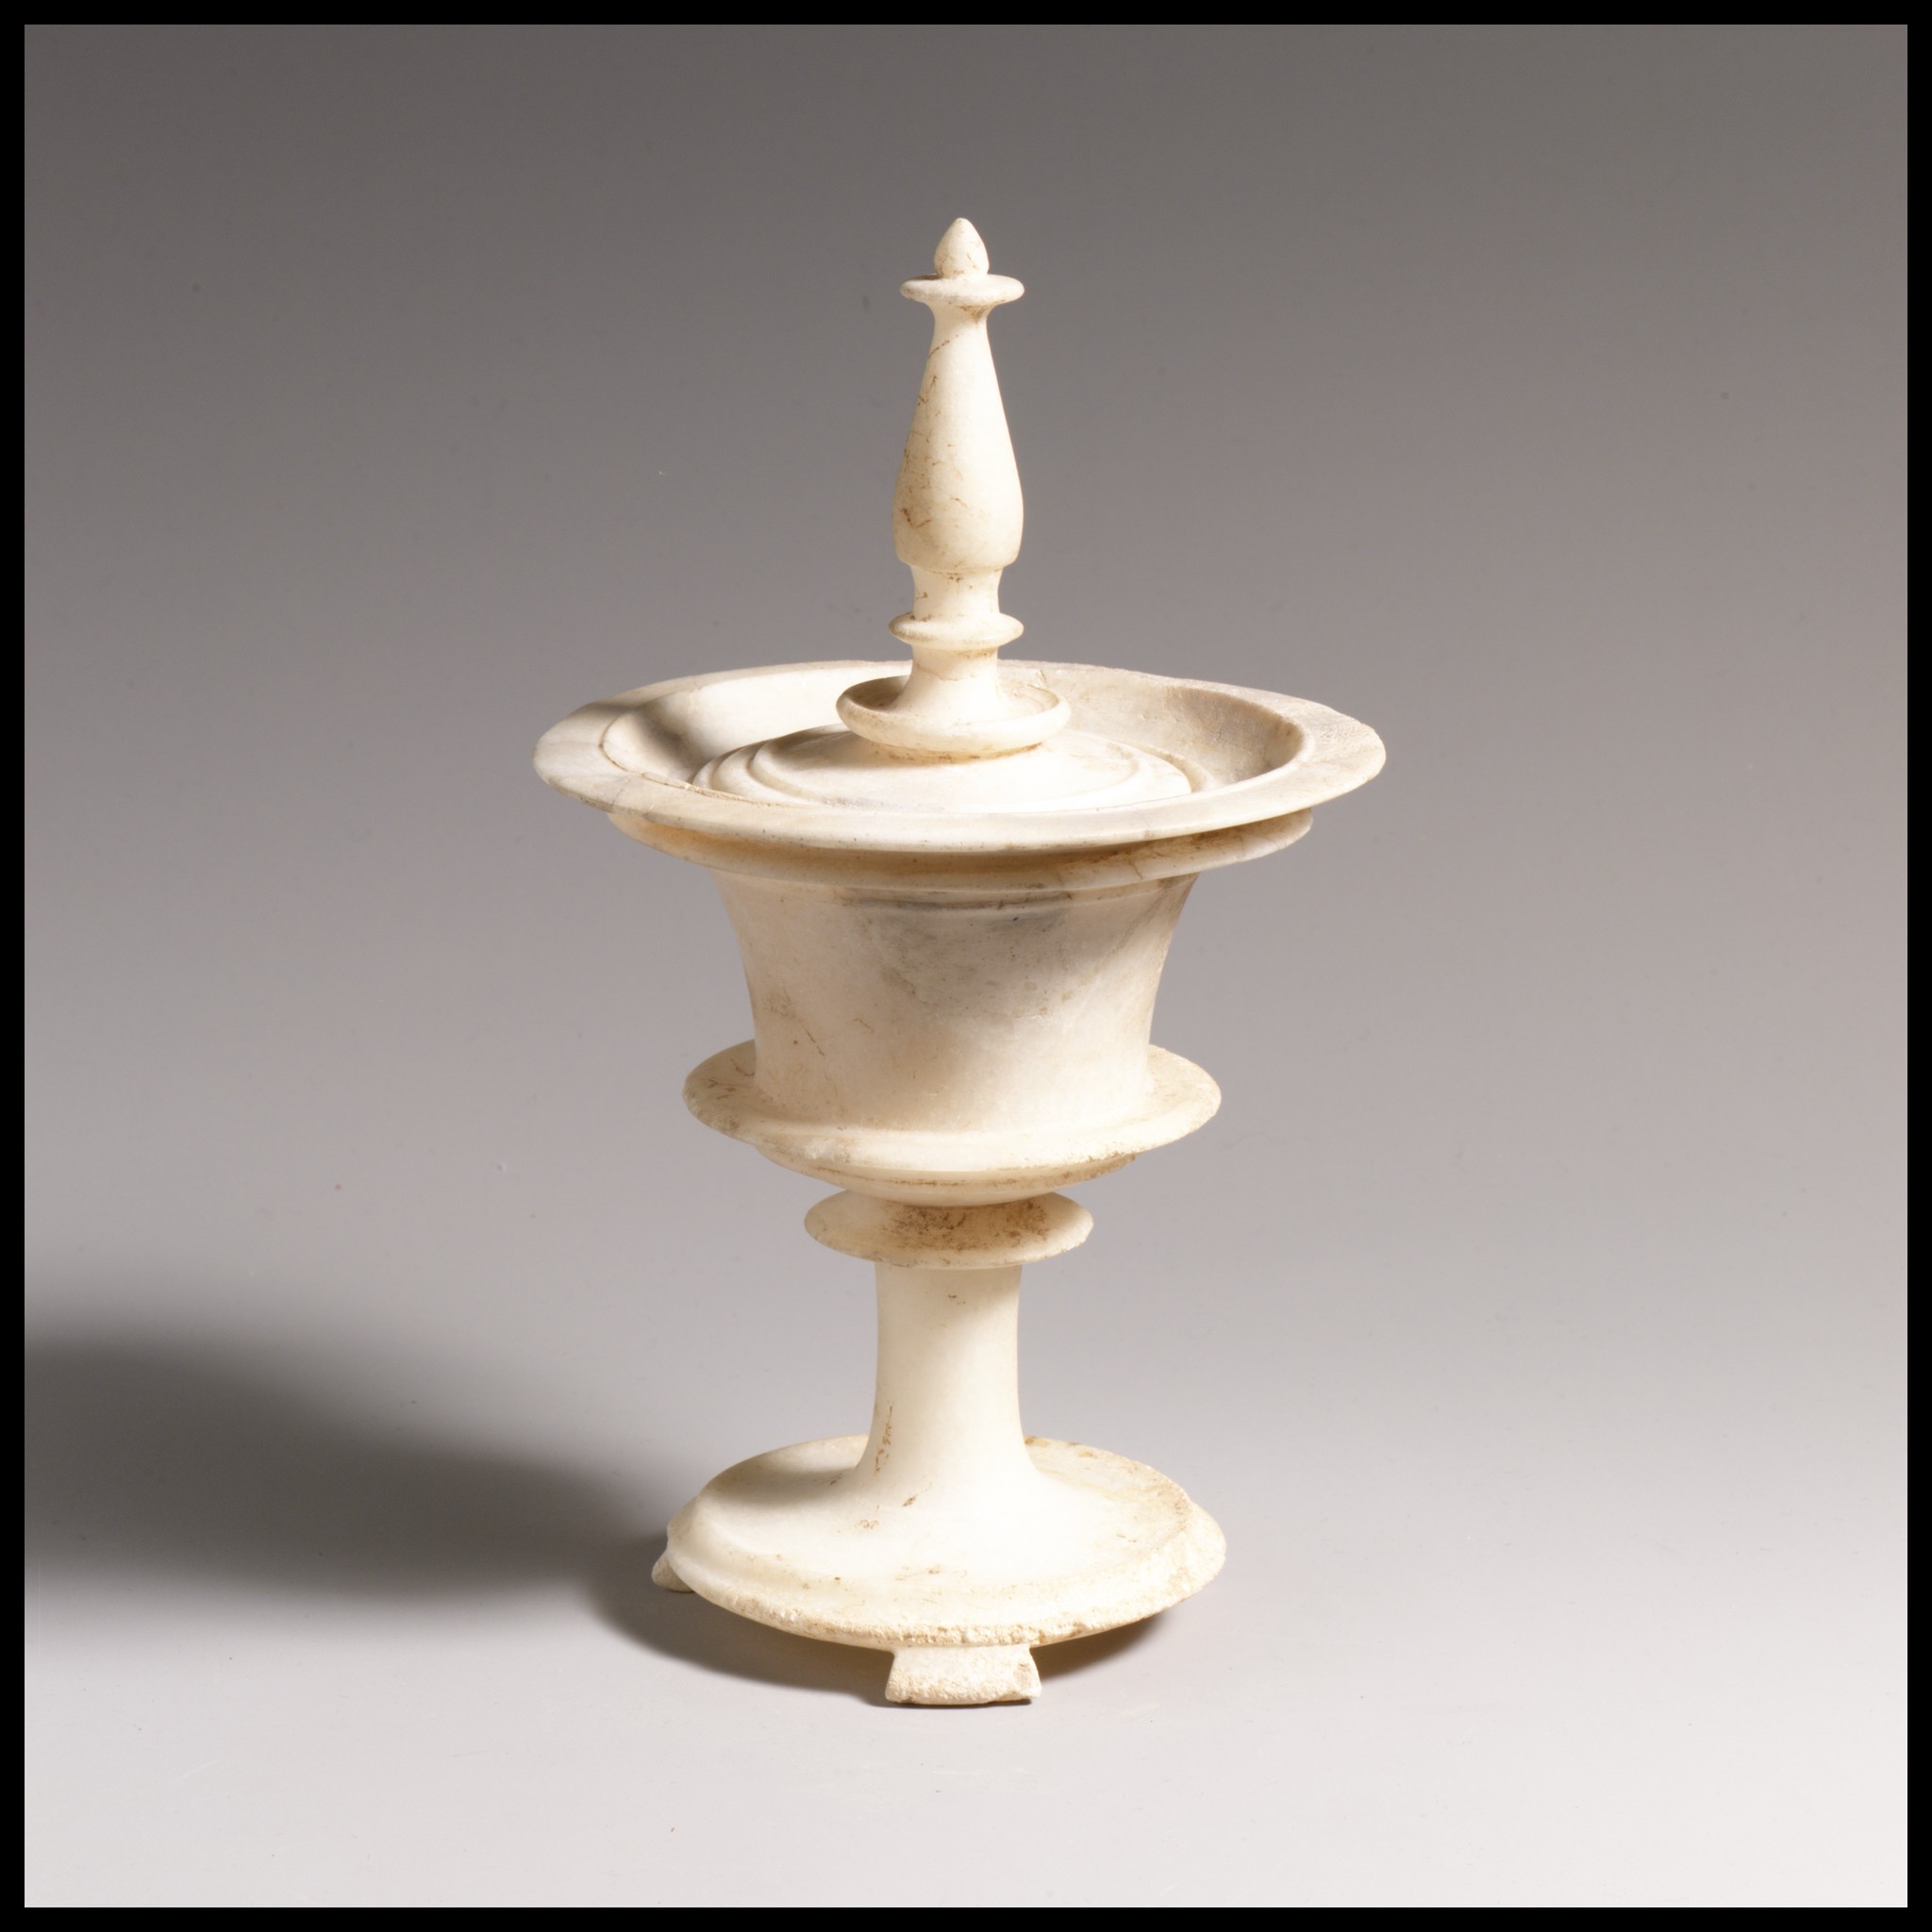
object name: pyxis, stemmed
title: Marble pyxis (box)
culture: greek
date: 434-368 BCE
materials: marble